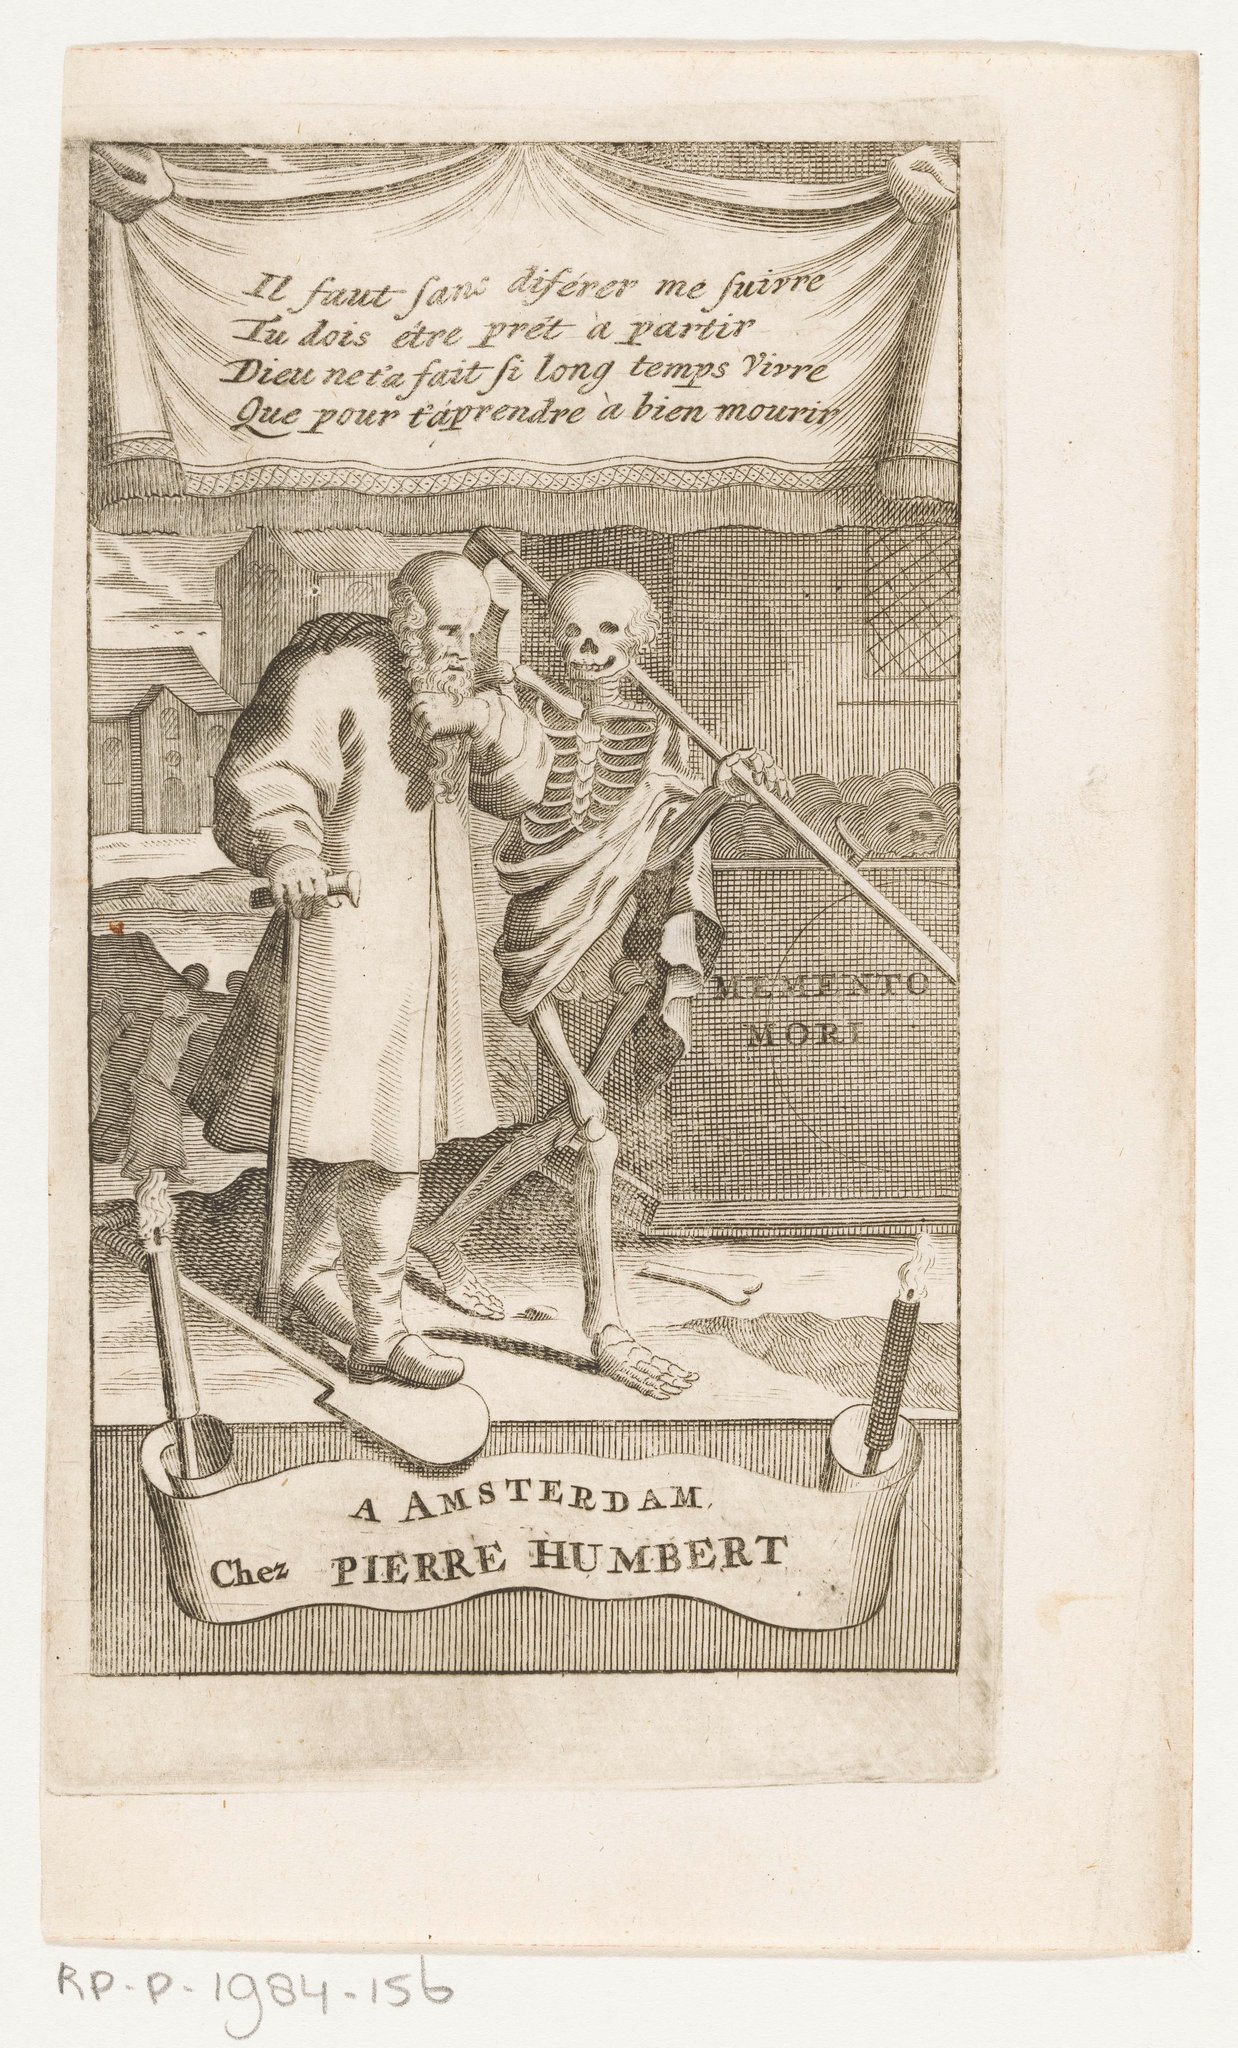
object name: print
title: Dood begeleidt oude man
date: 1712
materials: paper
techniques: etching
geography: amsterdam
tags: death as skeleton, old man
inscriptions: collector's mark: Lugt 2760, collector's mark: Lugt 2228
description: De Dood als skelet met zeis begeleidt een oude man met baard en wandelstok. Aan de bovenzijde een draperie met vierregelige Franse tekst.